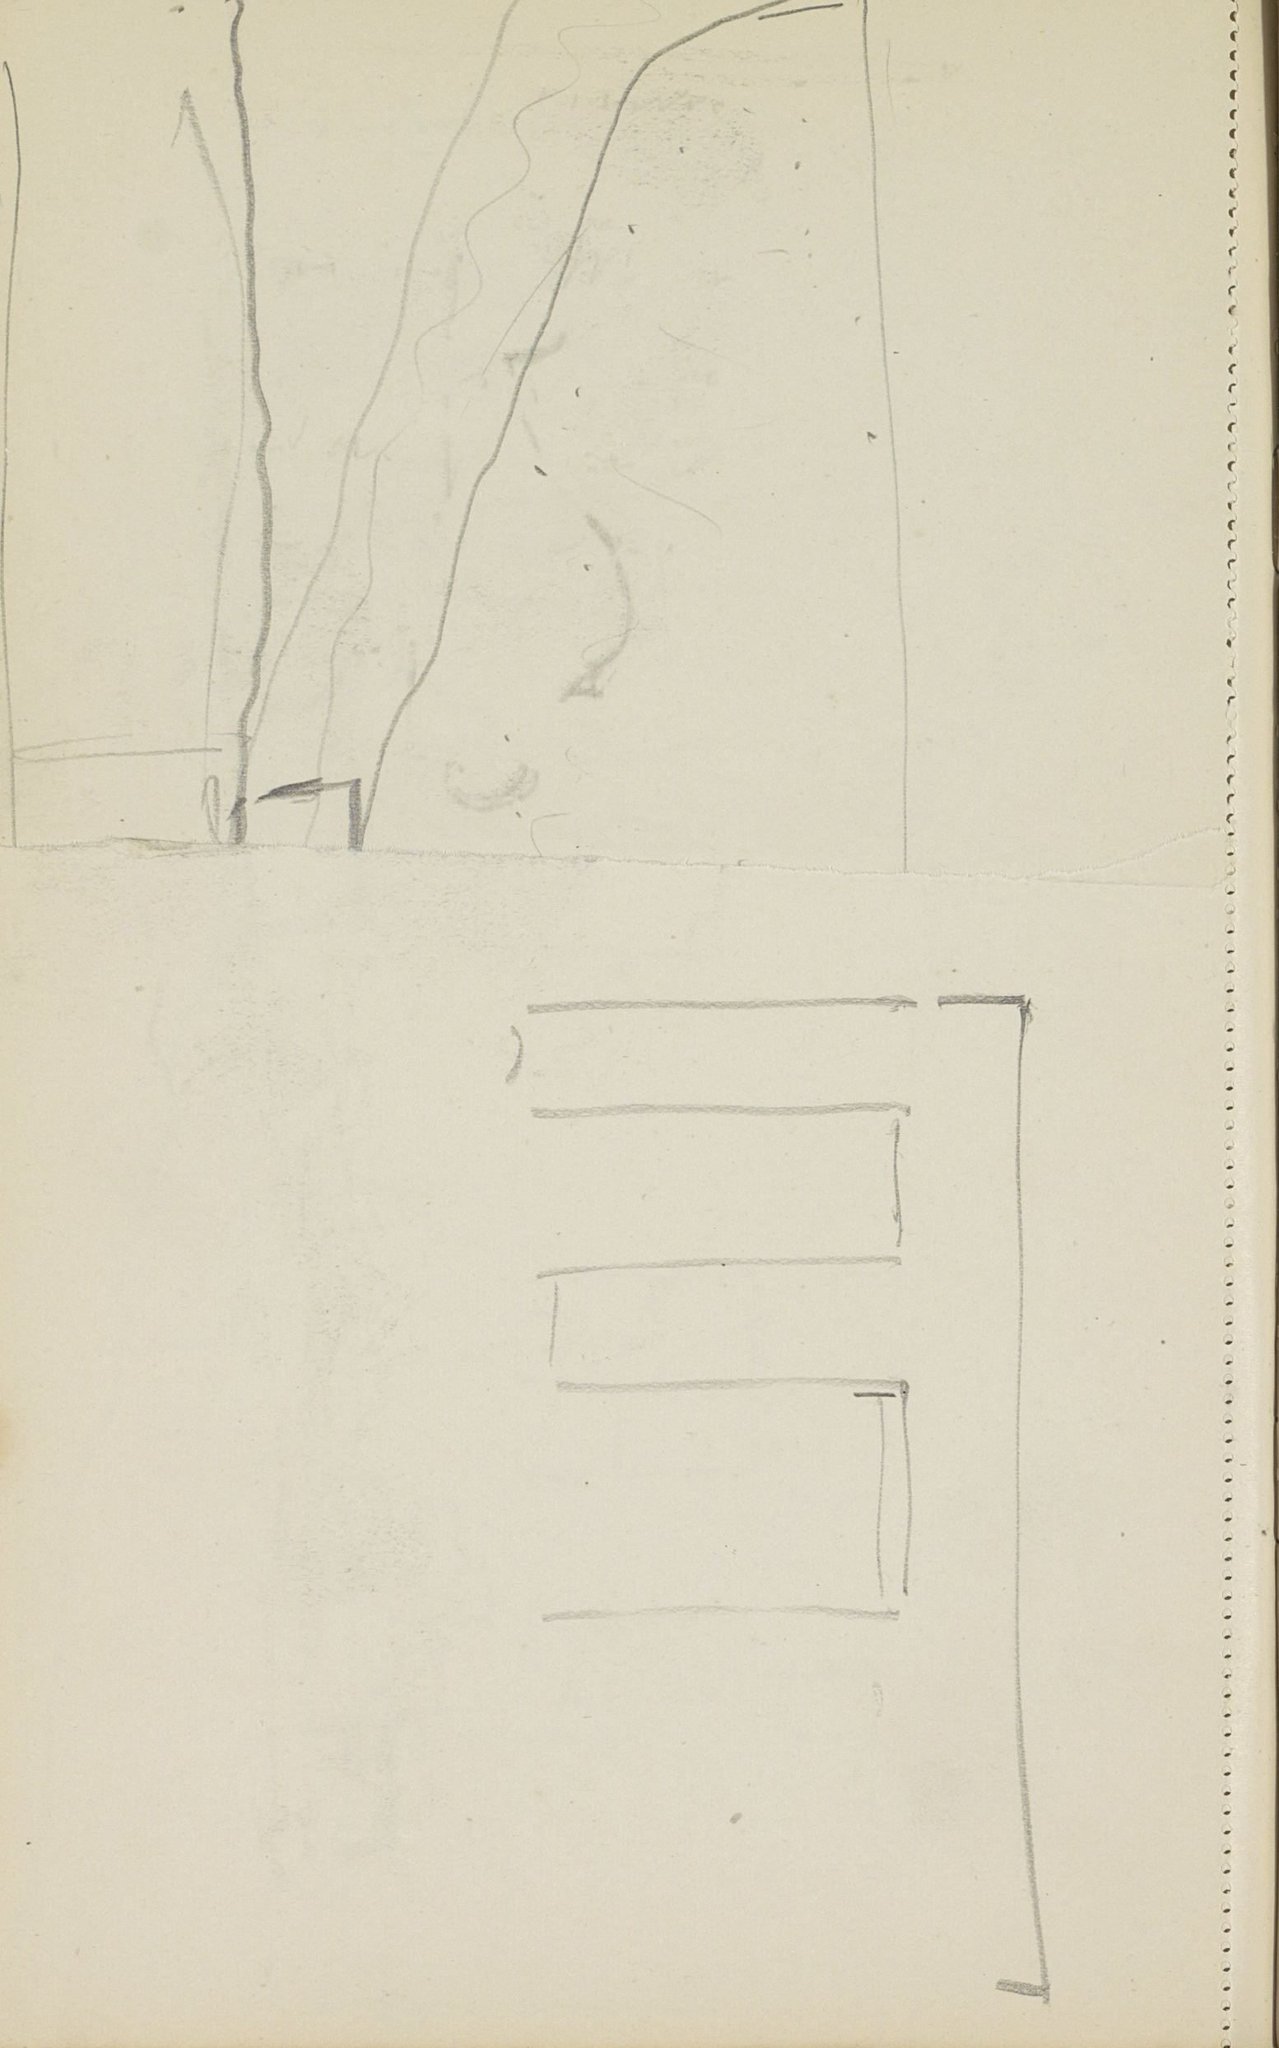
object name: sketchbook leaf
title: Rechthoekige vorm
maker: cornelis vreedenburgh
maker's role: draughtsman, print maker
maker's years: 1880-1946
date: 1890-1946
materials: paper, pencil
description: Blad 53 verso uit een schetsboek met 56 bladen.